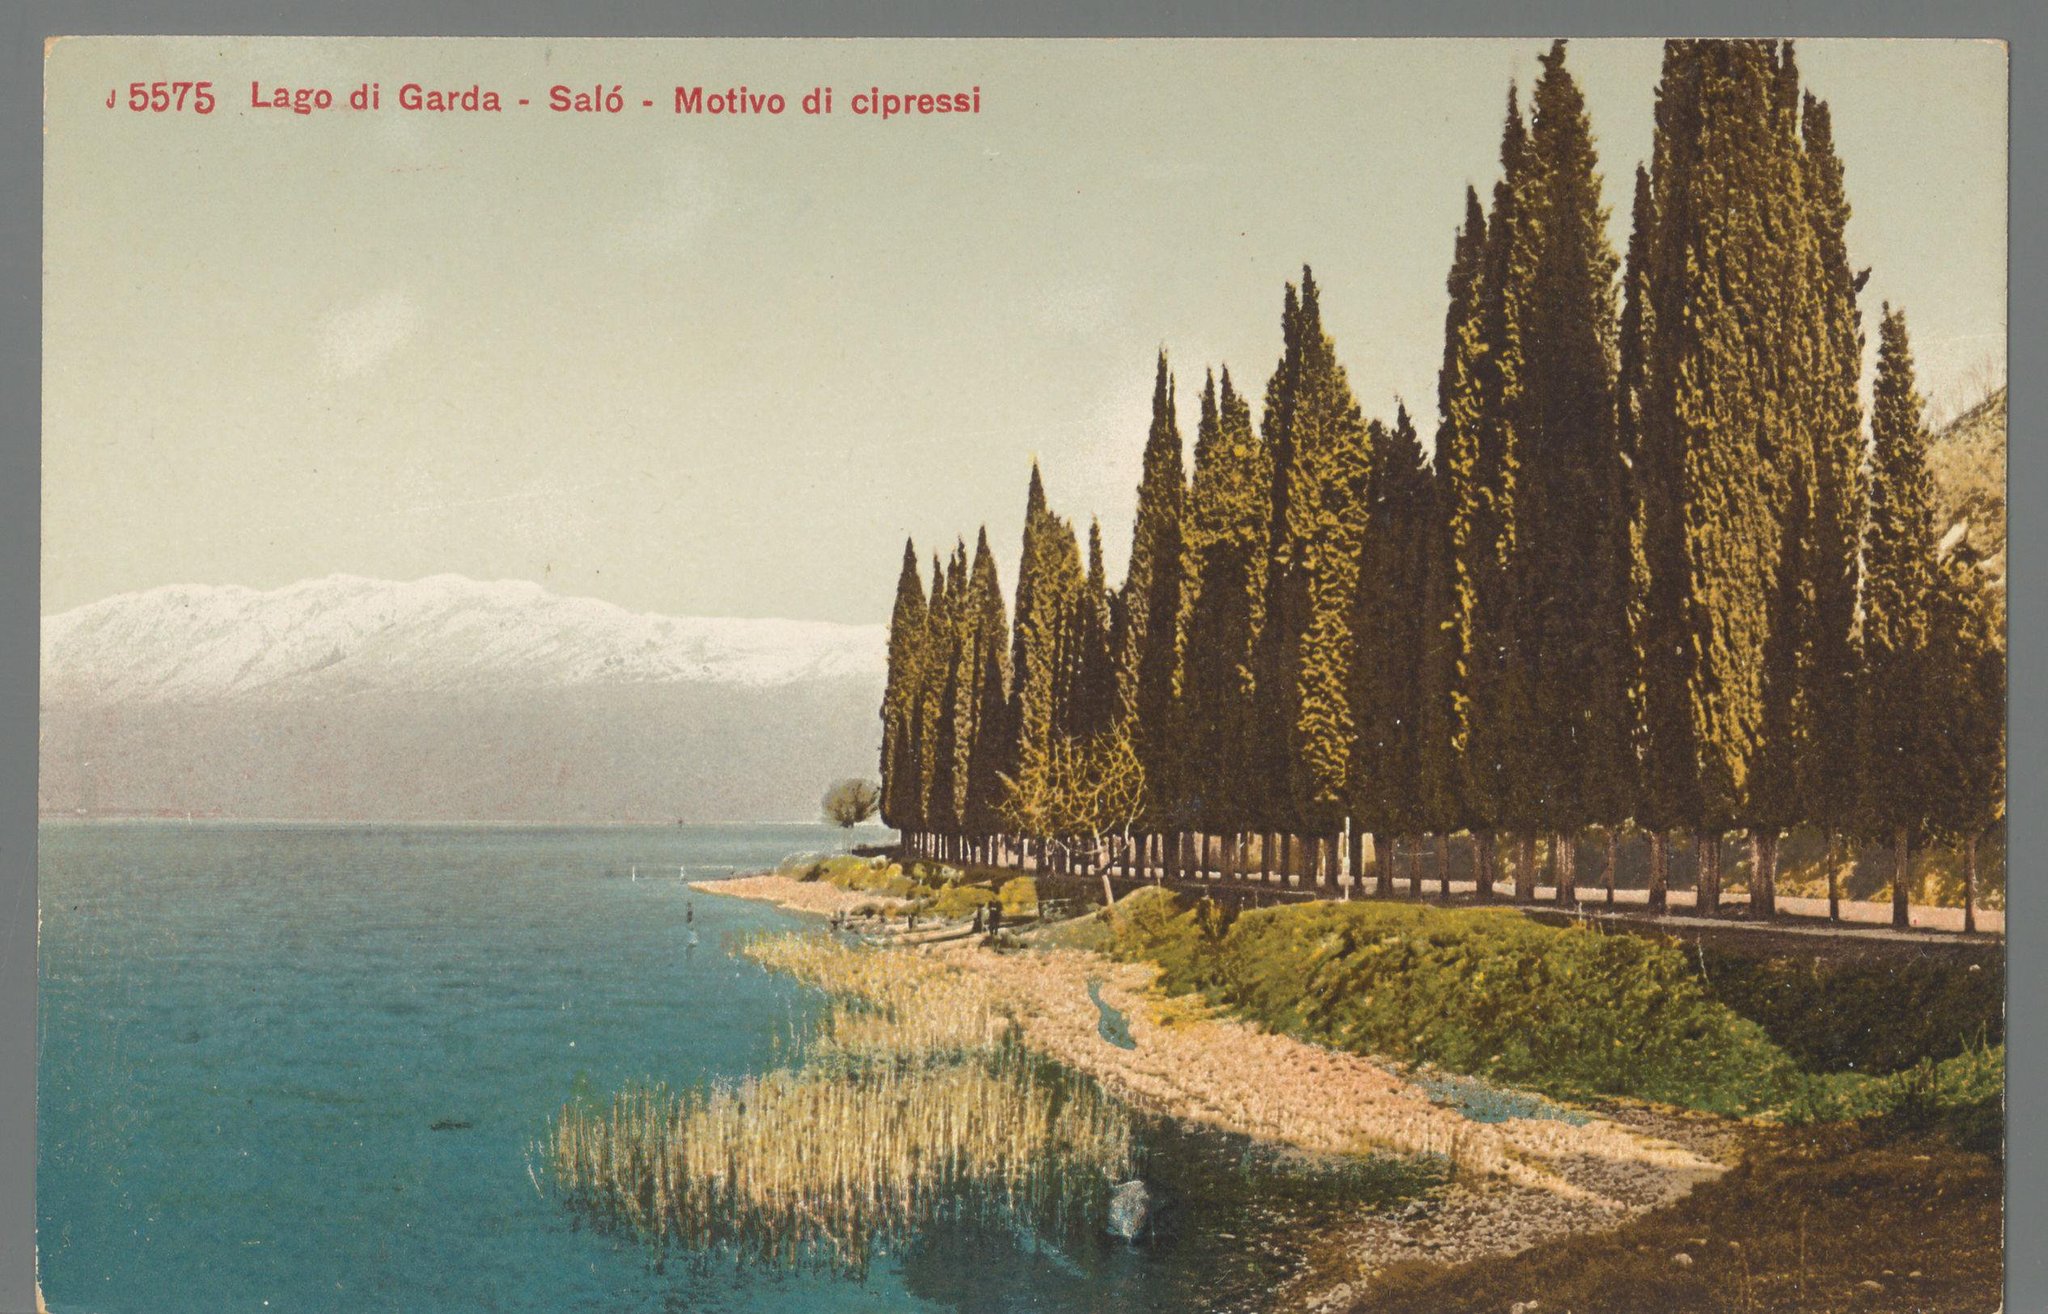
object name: ansichtkaart, prentbriefkaart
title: Lago di Garda. Saló. Motivo di cipressi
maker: Anonymous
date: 1905-1930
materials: cardboard, photographic process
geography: zurich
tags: trees: cypress, lake, mountains